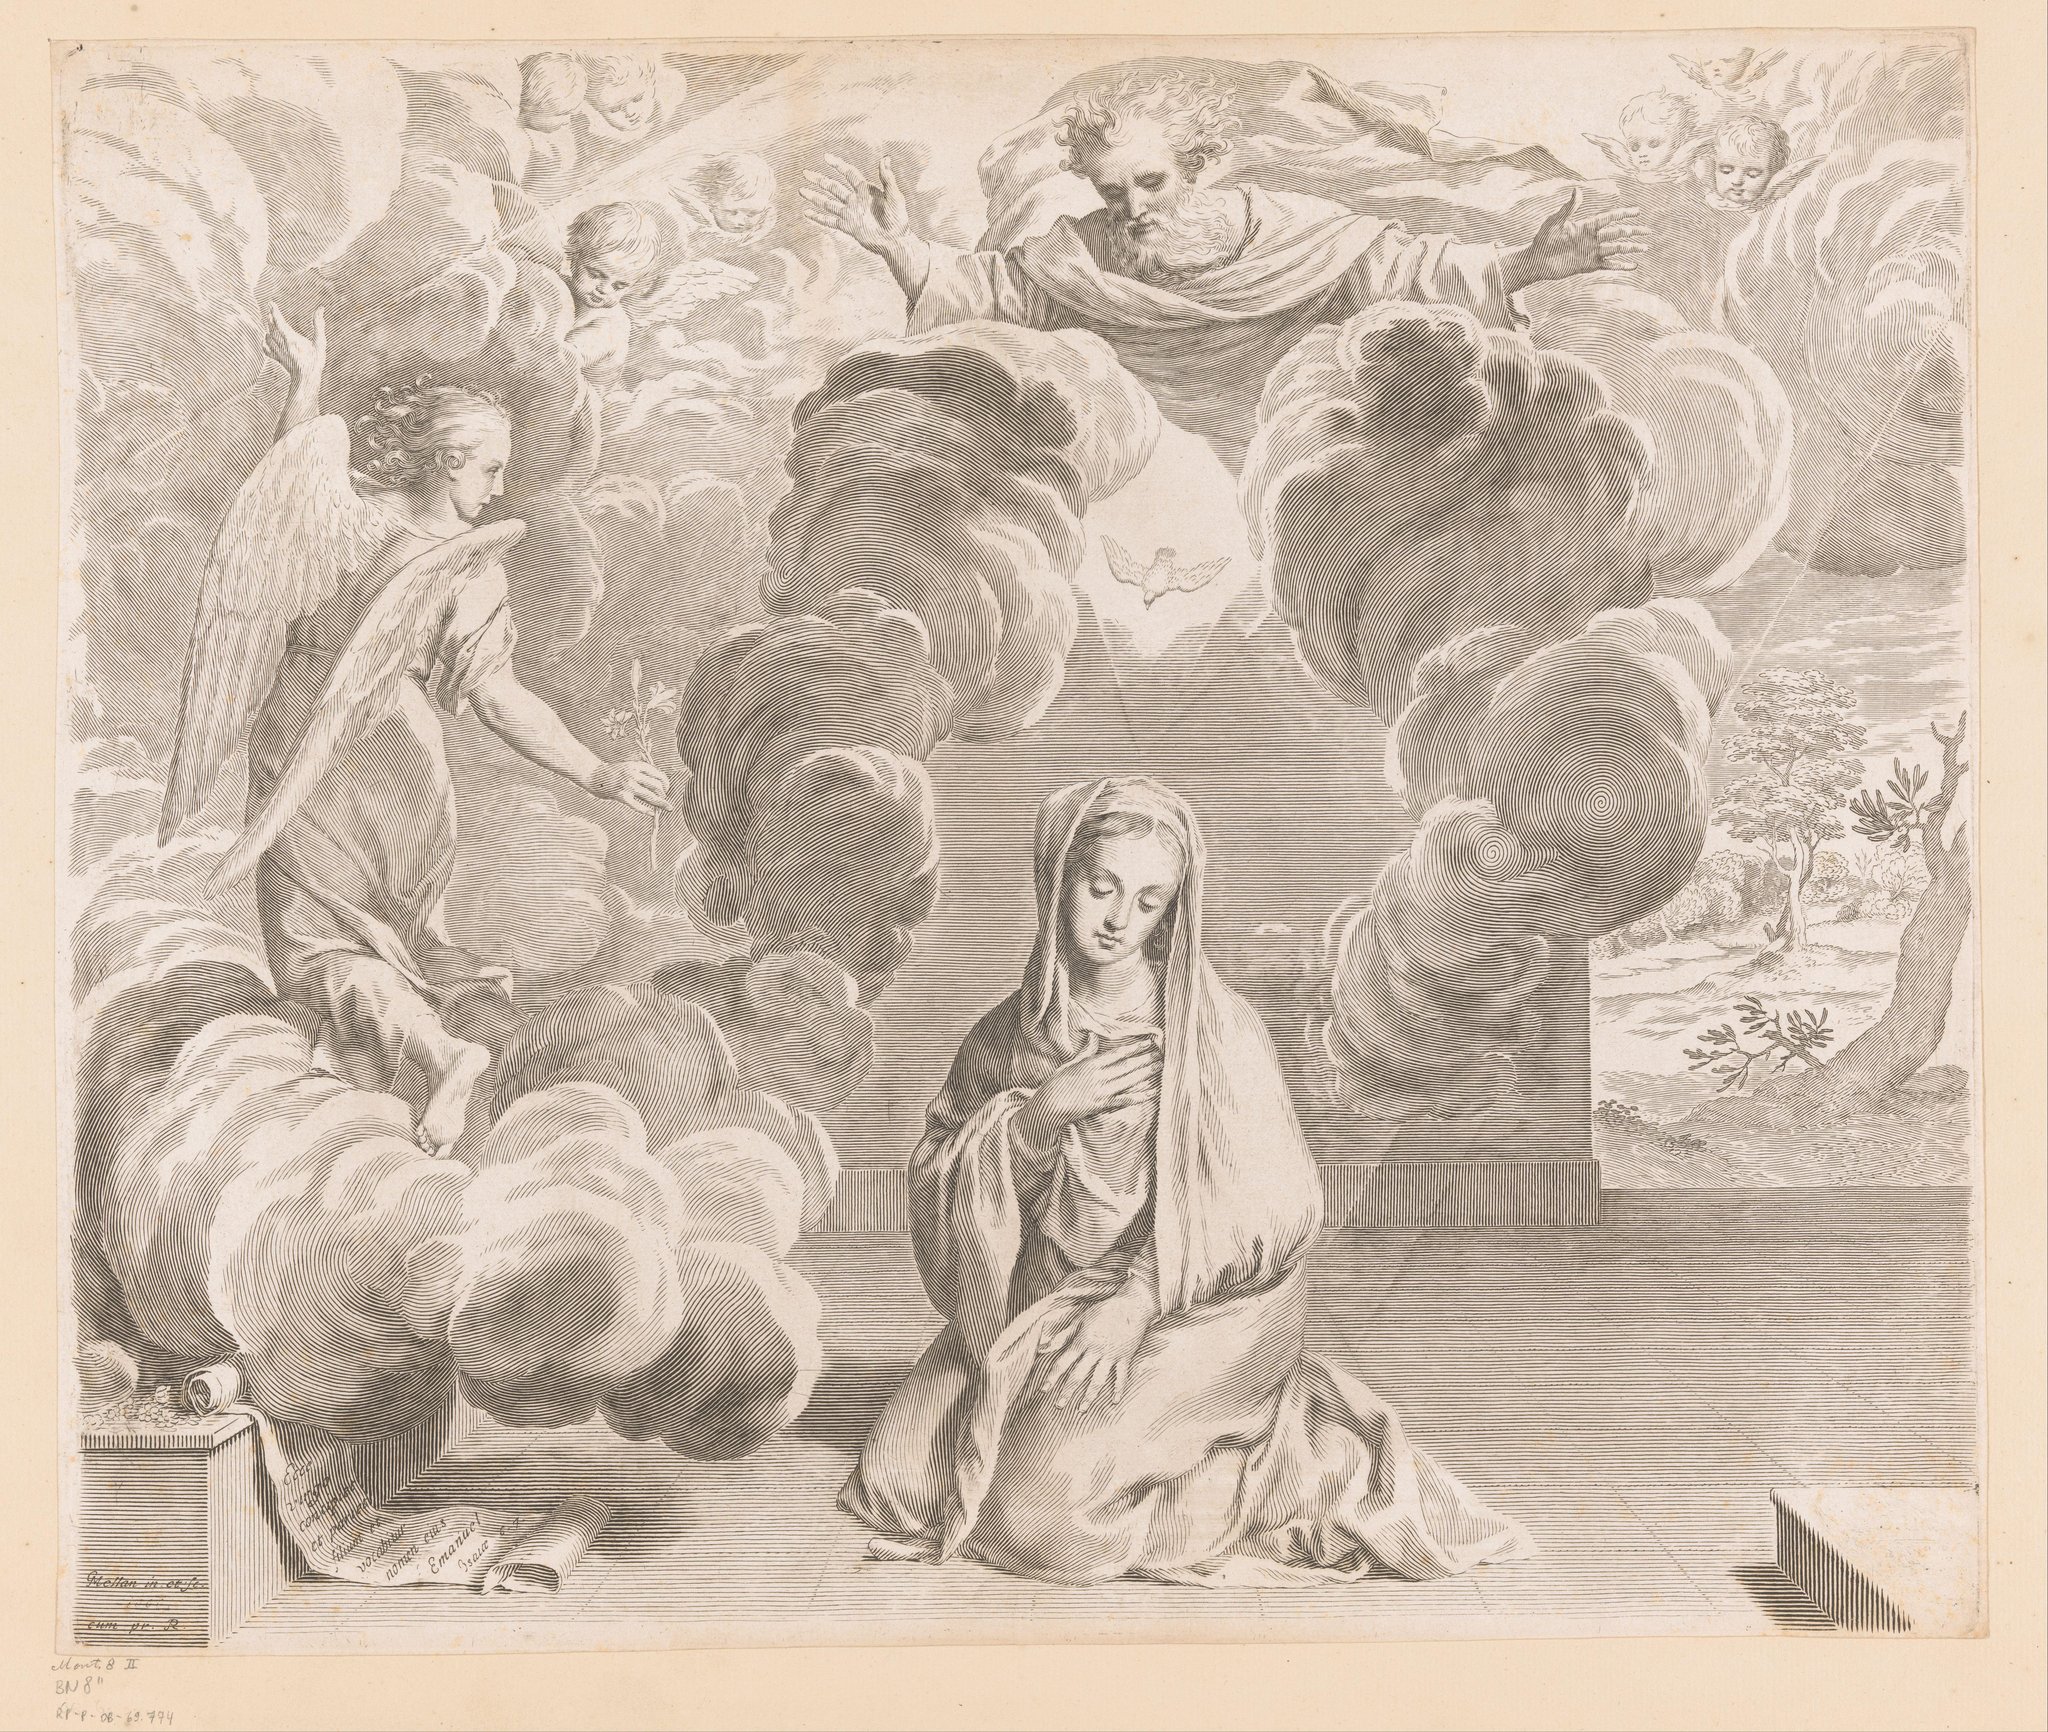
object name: print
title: Annunciatie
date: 1666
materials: paper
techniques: engraving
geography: france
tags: the annunciation: mary kneeling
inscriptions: collector's mark: Lugt 240